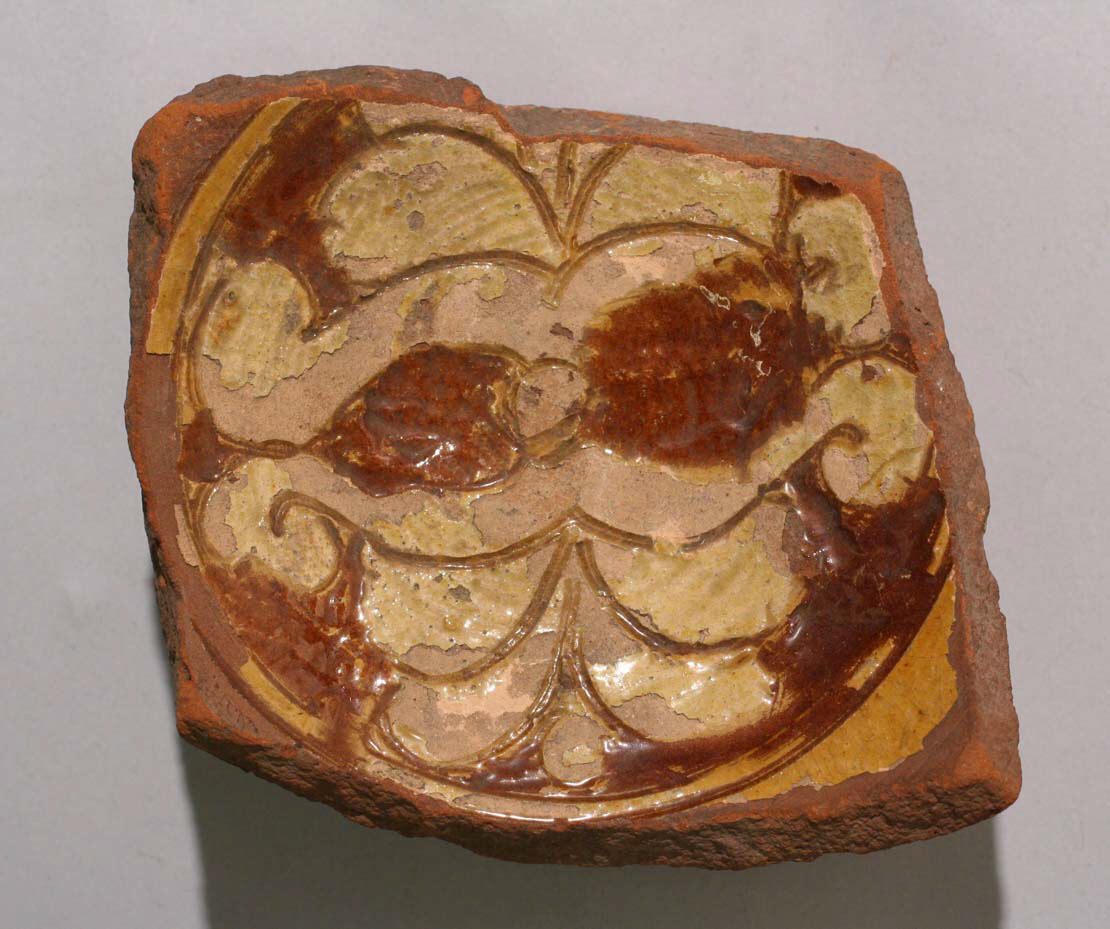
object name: fragment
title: Fragment of a Bowl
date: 1301-1500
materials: earthenware, glaze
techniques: coloring, incising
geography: egypt